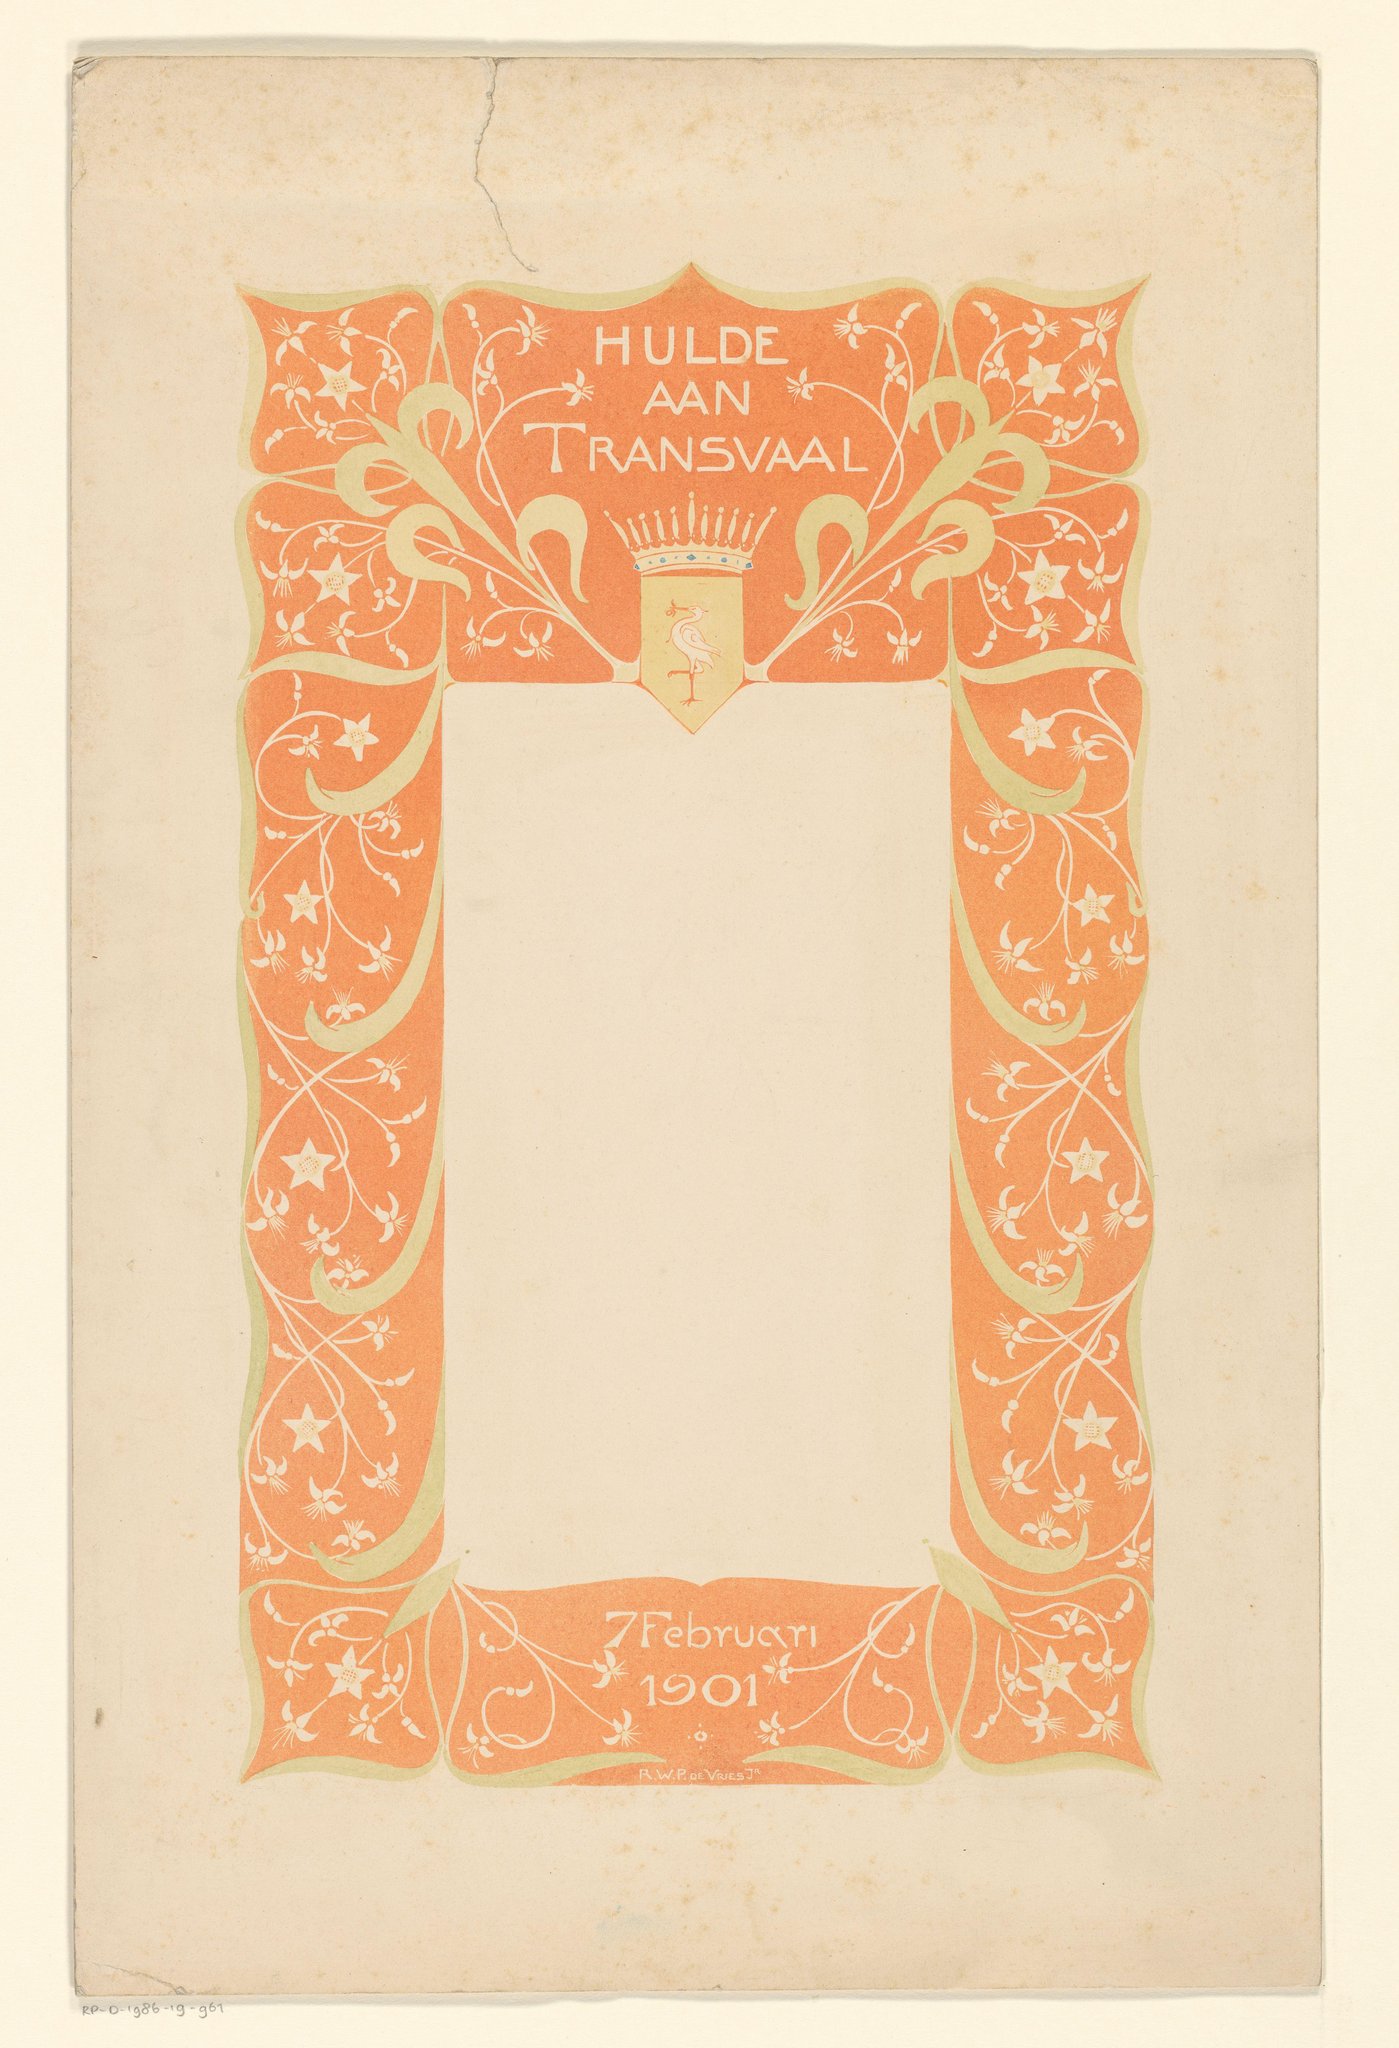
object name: print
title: Decoratief kader met wapen van Den Haag, kroon en bloemornamenten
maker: reinier willem petrus de vries (1874-1953)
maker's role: draughtsman, print maker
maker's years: 1874-1953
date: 1901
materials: paper, pencil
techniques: hand coloring, lithograph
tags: city-crown, mural crown, coat of arms (as symbol of the state, etc.) (+ city; municipal), flowers ~ ornament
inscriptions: collector's mark: ‘R:MVS.’